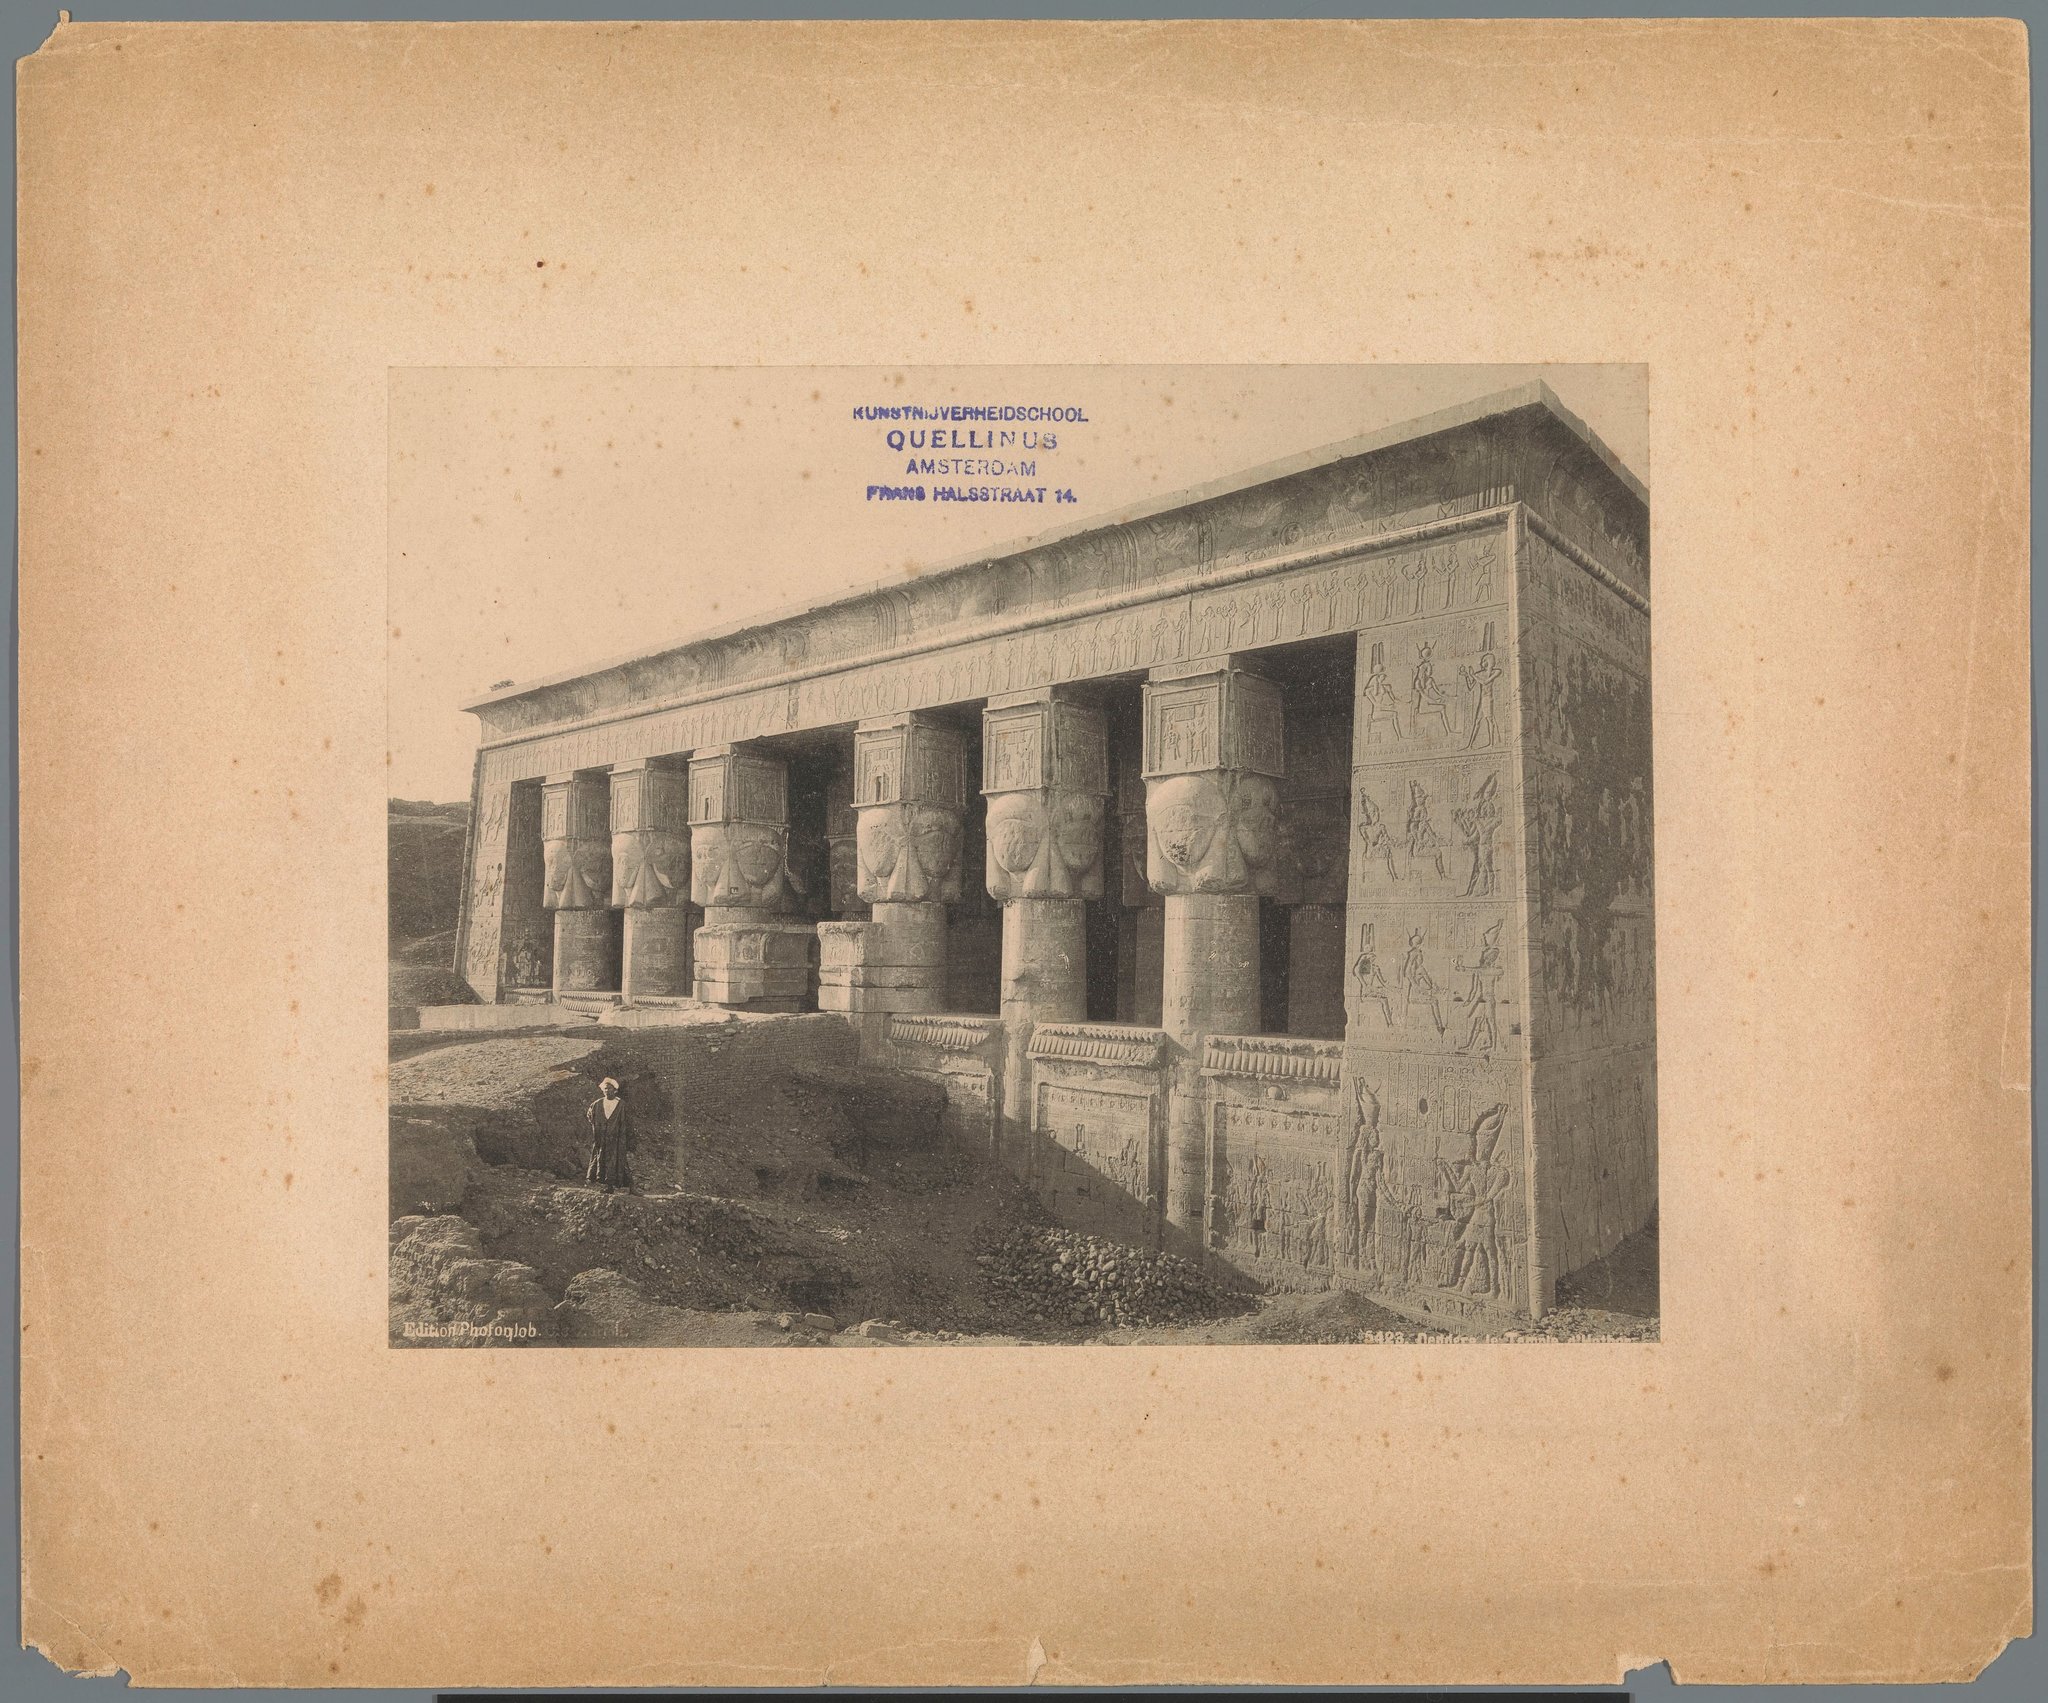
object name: photograph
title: Dendere le Temple d'Hathor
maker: Anonymous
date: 1875-1900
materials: cardboard, ink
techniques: photograph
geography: dendera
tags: column, pillar ~ architecture, temple, shrine ~ non-christian religions, façade (of house or building), sculpture (+ relief ~ sculpture)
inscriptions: number: ‘5423.’, name: ‘J.H. DE WIT. Boek-en Kunsthandel Utrechtsche Straat 54, AMSTERDAM.’, collector's mark: ‘INSTITUUT VOOR KUNST- NIJVERHEIDSONDERWIJS GABRIËL METSUSTRAAT No. 16. AMSTERDAM’, collector's mark: ‘KUNSTNIJVERHEIDSCHOOL QUELLINUS AMSTERDAM FRANS HALSSTRAAT 14.’